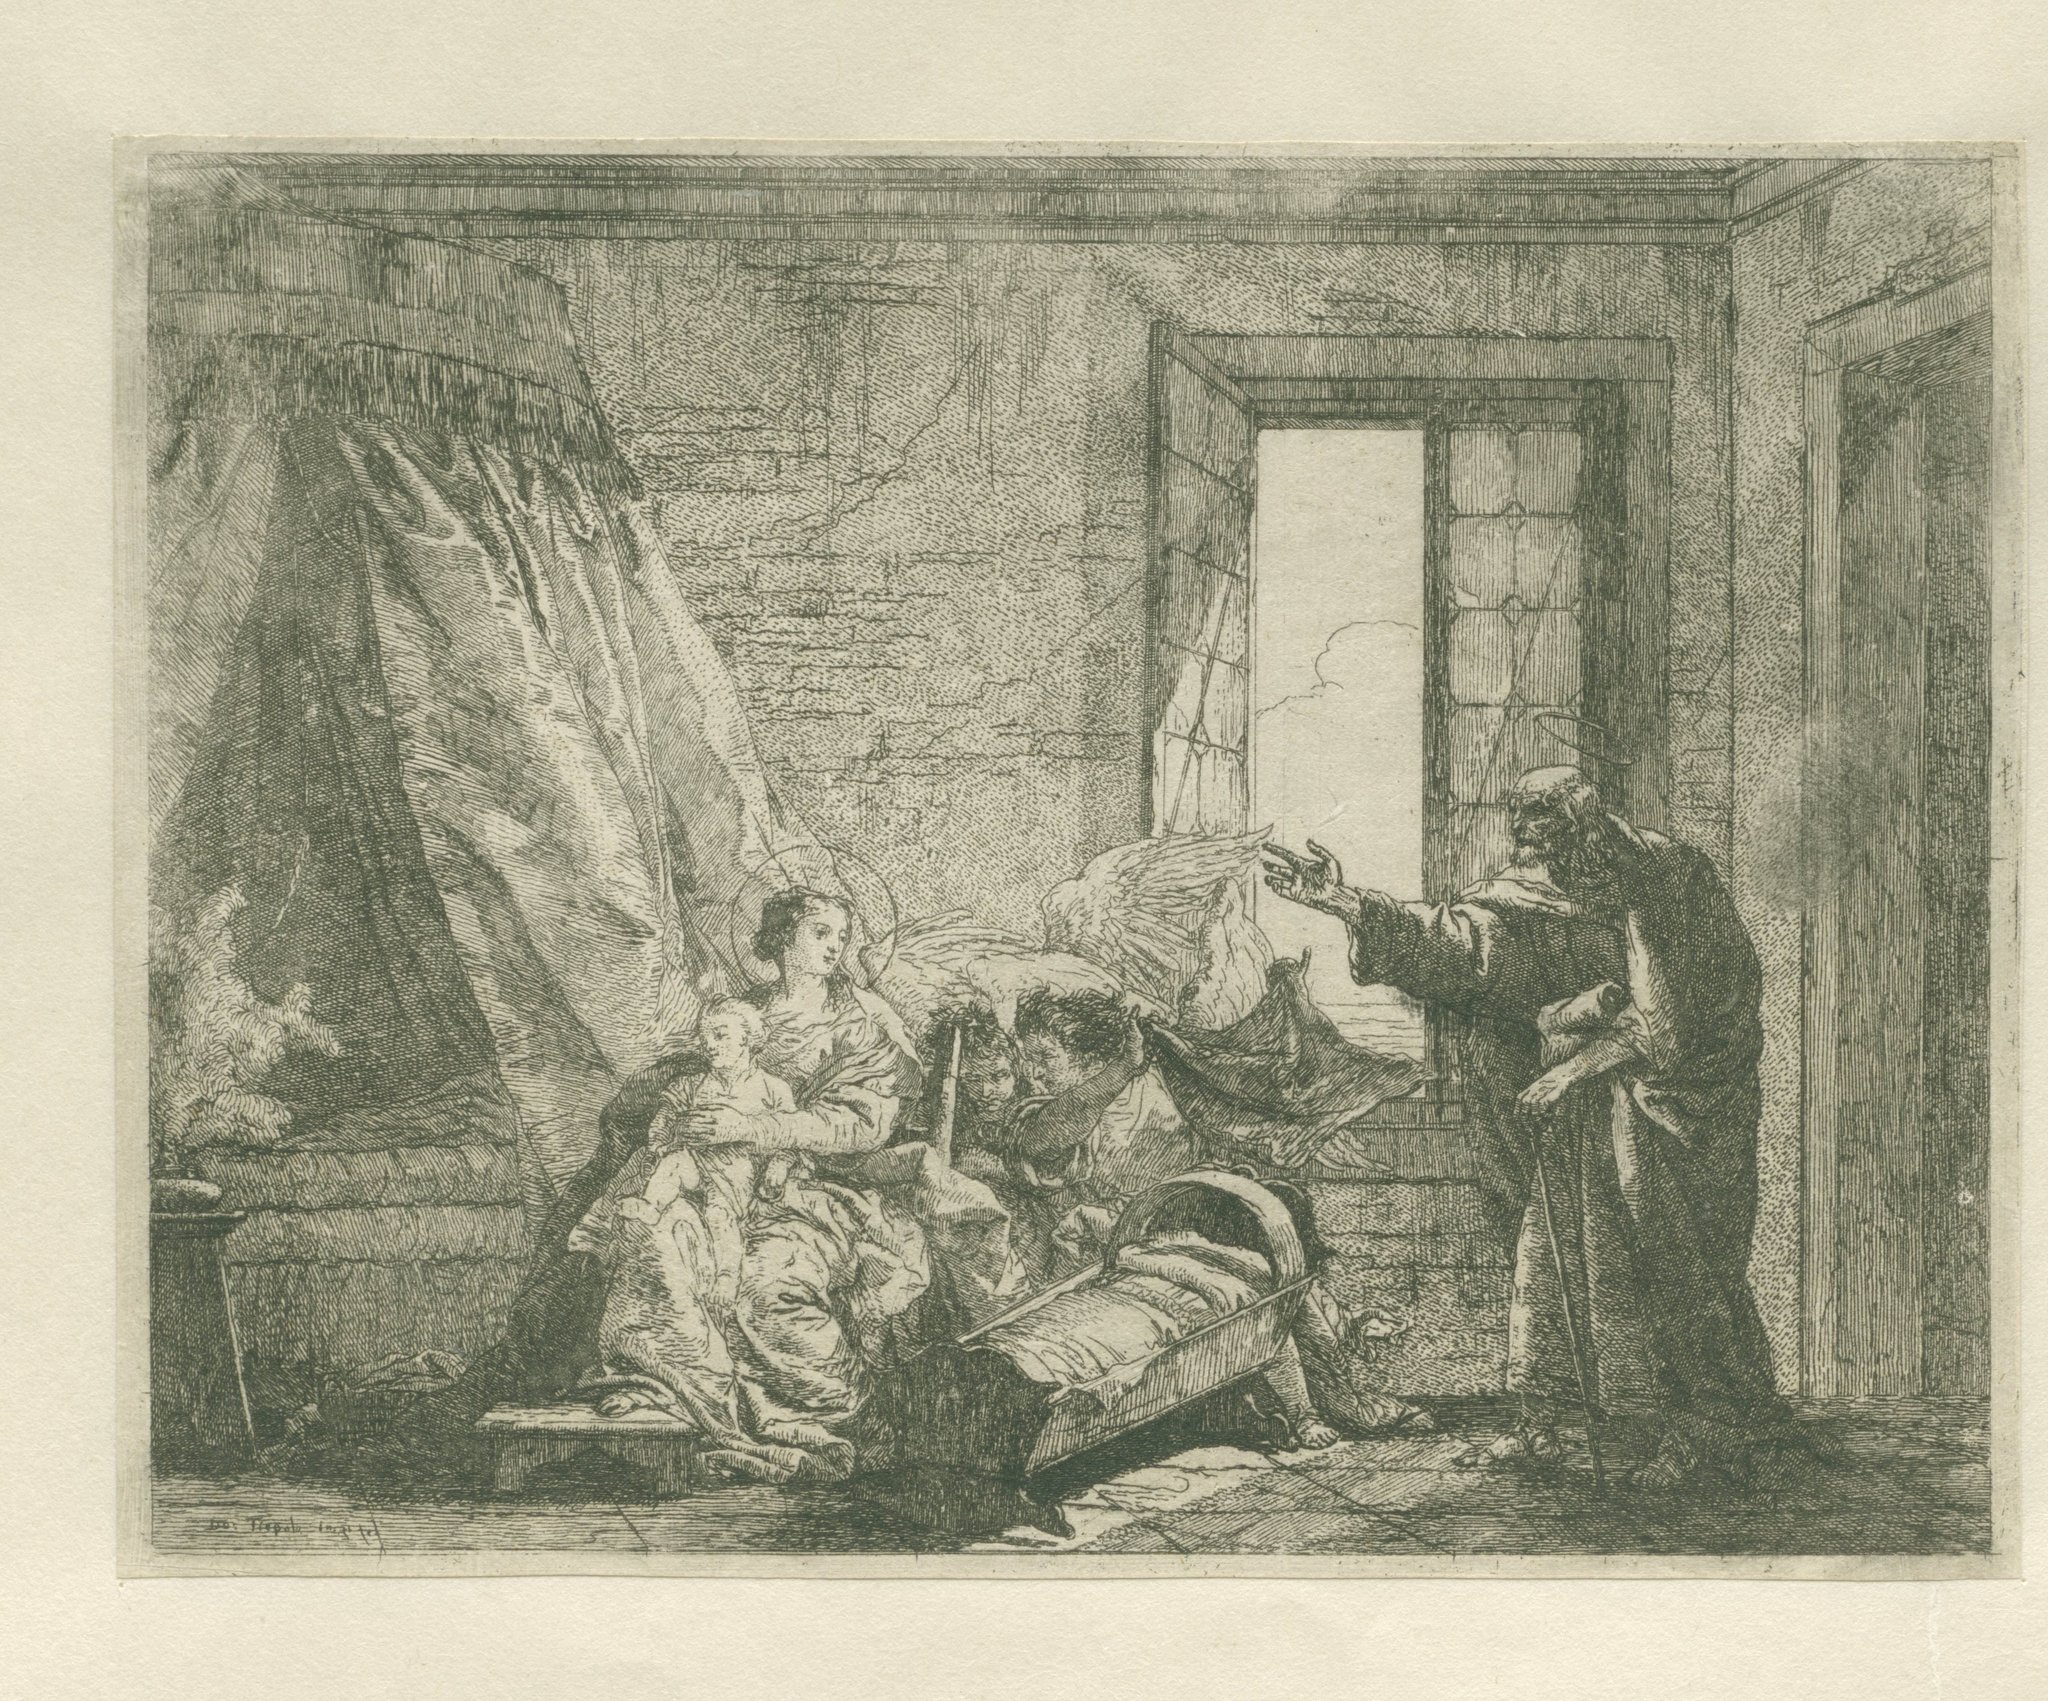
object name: print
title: Joseph Telling Mary about their Flight into Egypt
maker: giovanni domenico tiepolo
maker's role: draughtsman, print maker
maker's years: 1727-1804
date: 1750-1753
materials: paper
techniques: etching, intaglio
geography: venice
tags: bed with tester, an angel appearing to joseph in a dream summons him to flee into egypt, cradle, crib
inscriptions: collector's mark: Lugt 2760, collector's mark: Lugt 2228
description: In a dream an angel instructs Joseph to flee with his wife and child to Egypt. This is the first print in the series Idee pittoresche sopra la fuga in Egitto (Picturesque ideas about the flight into Egypt) by Tiepolo’s eldest son. The Tiepolos usually pulled their etchings from copper plates wiped clean of excess ink. Here, however, some ink was left on the plate, creating an atmospheric, misty effect.